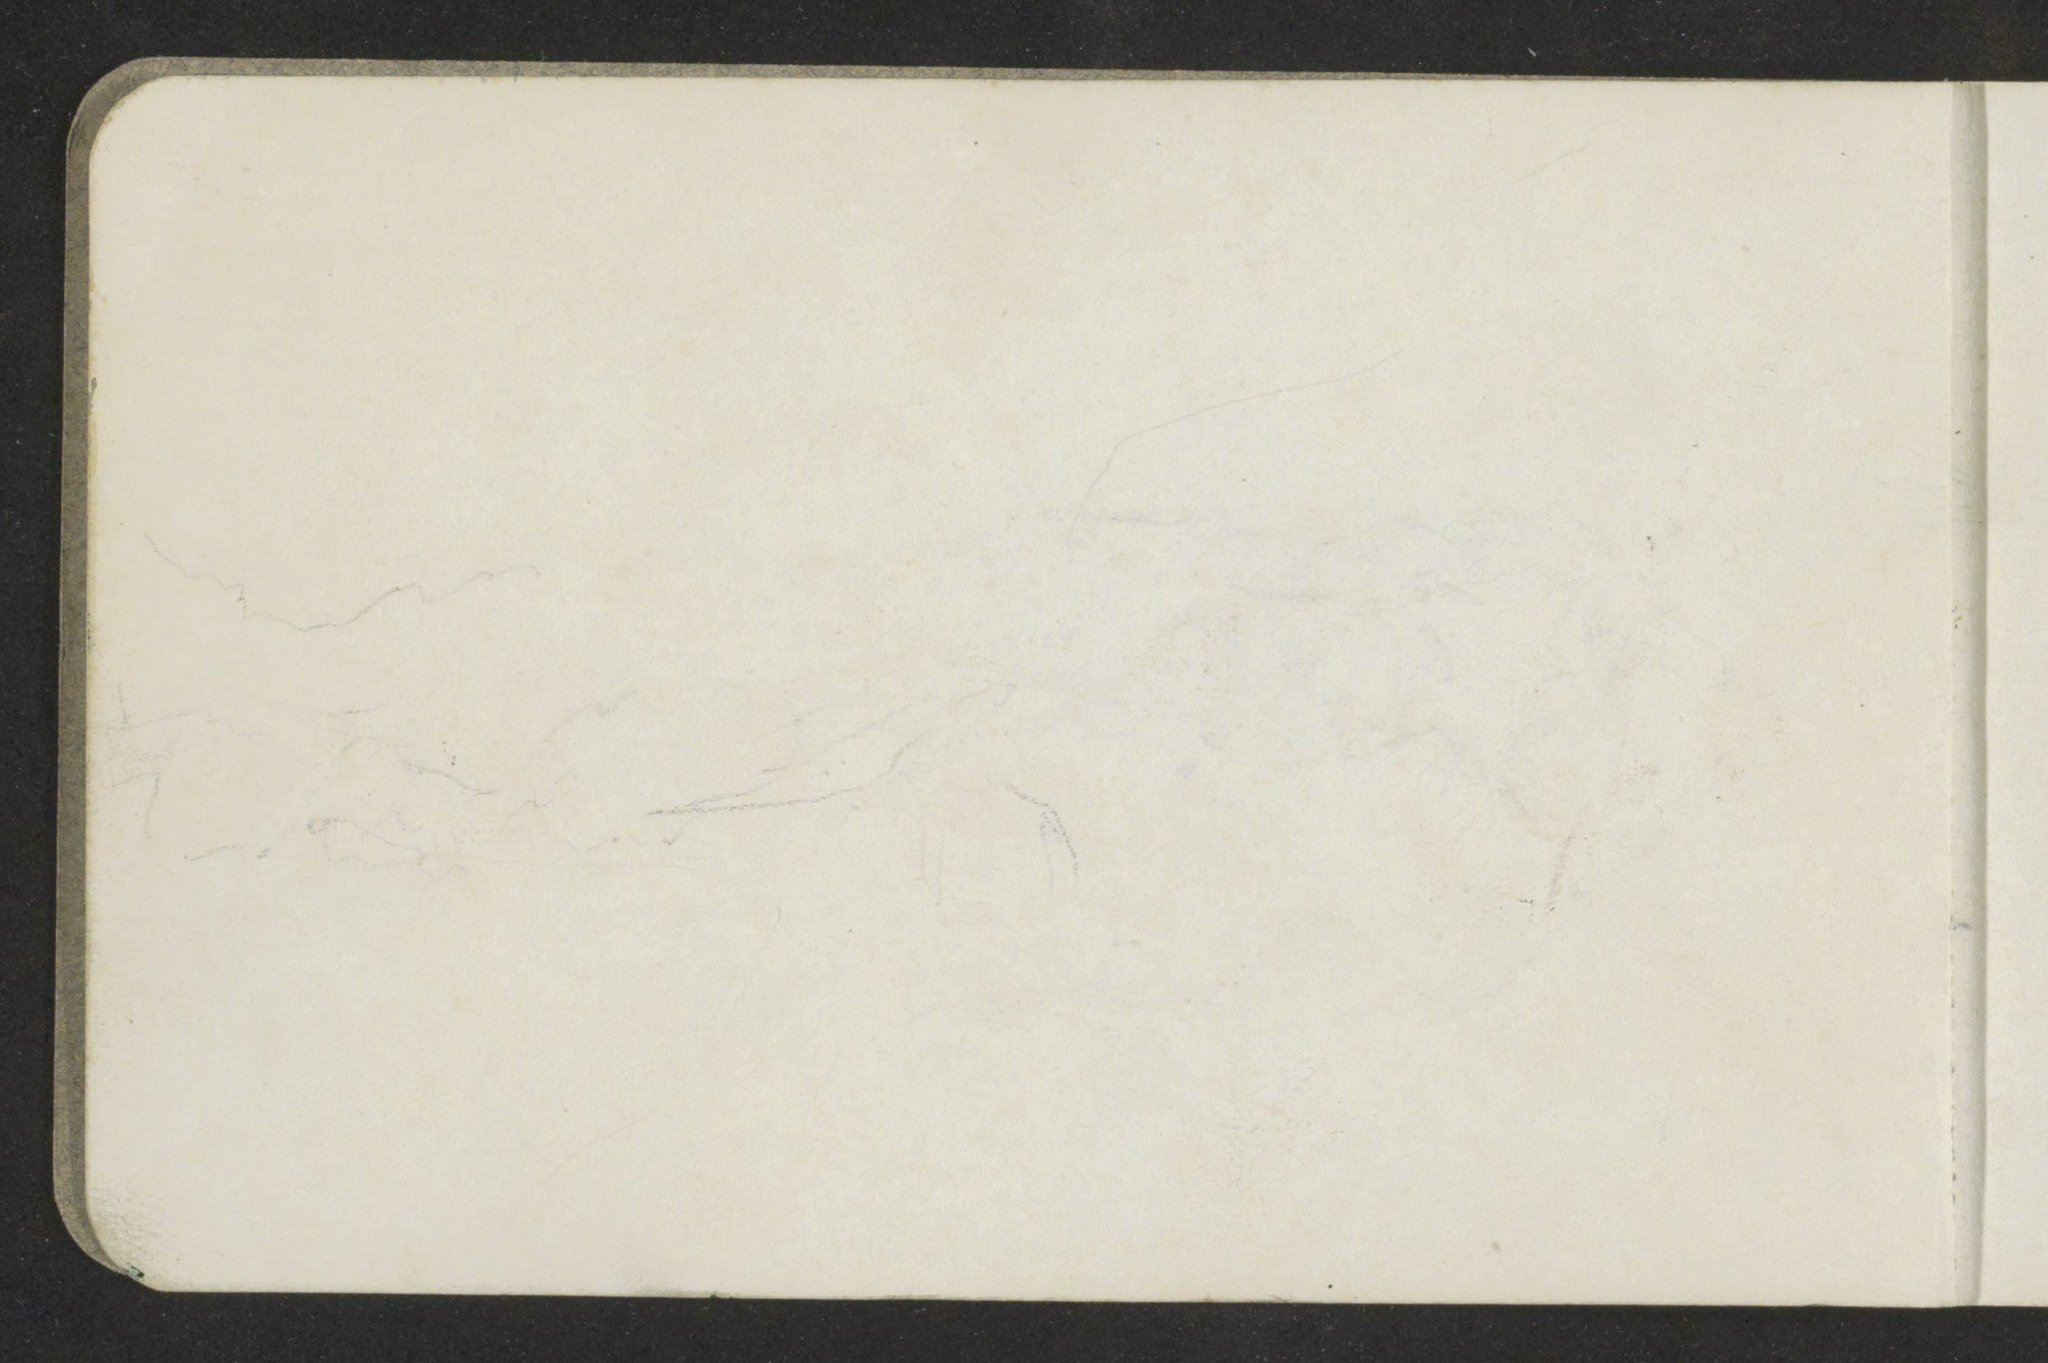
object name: sketchbook leaf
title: Studie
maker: jozef israëls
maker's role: draughtsman, painter, print maker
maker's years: 1824-1911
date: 1869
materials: paper, pencil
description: Blad 1 verso uit een schetsboek met 36 bladen.